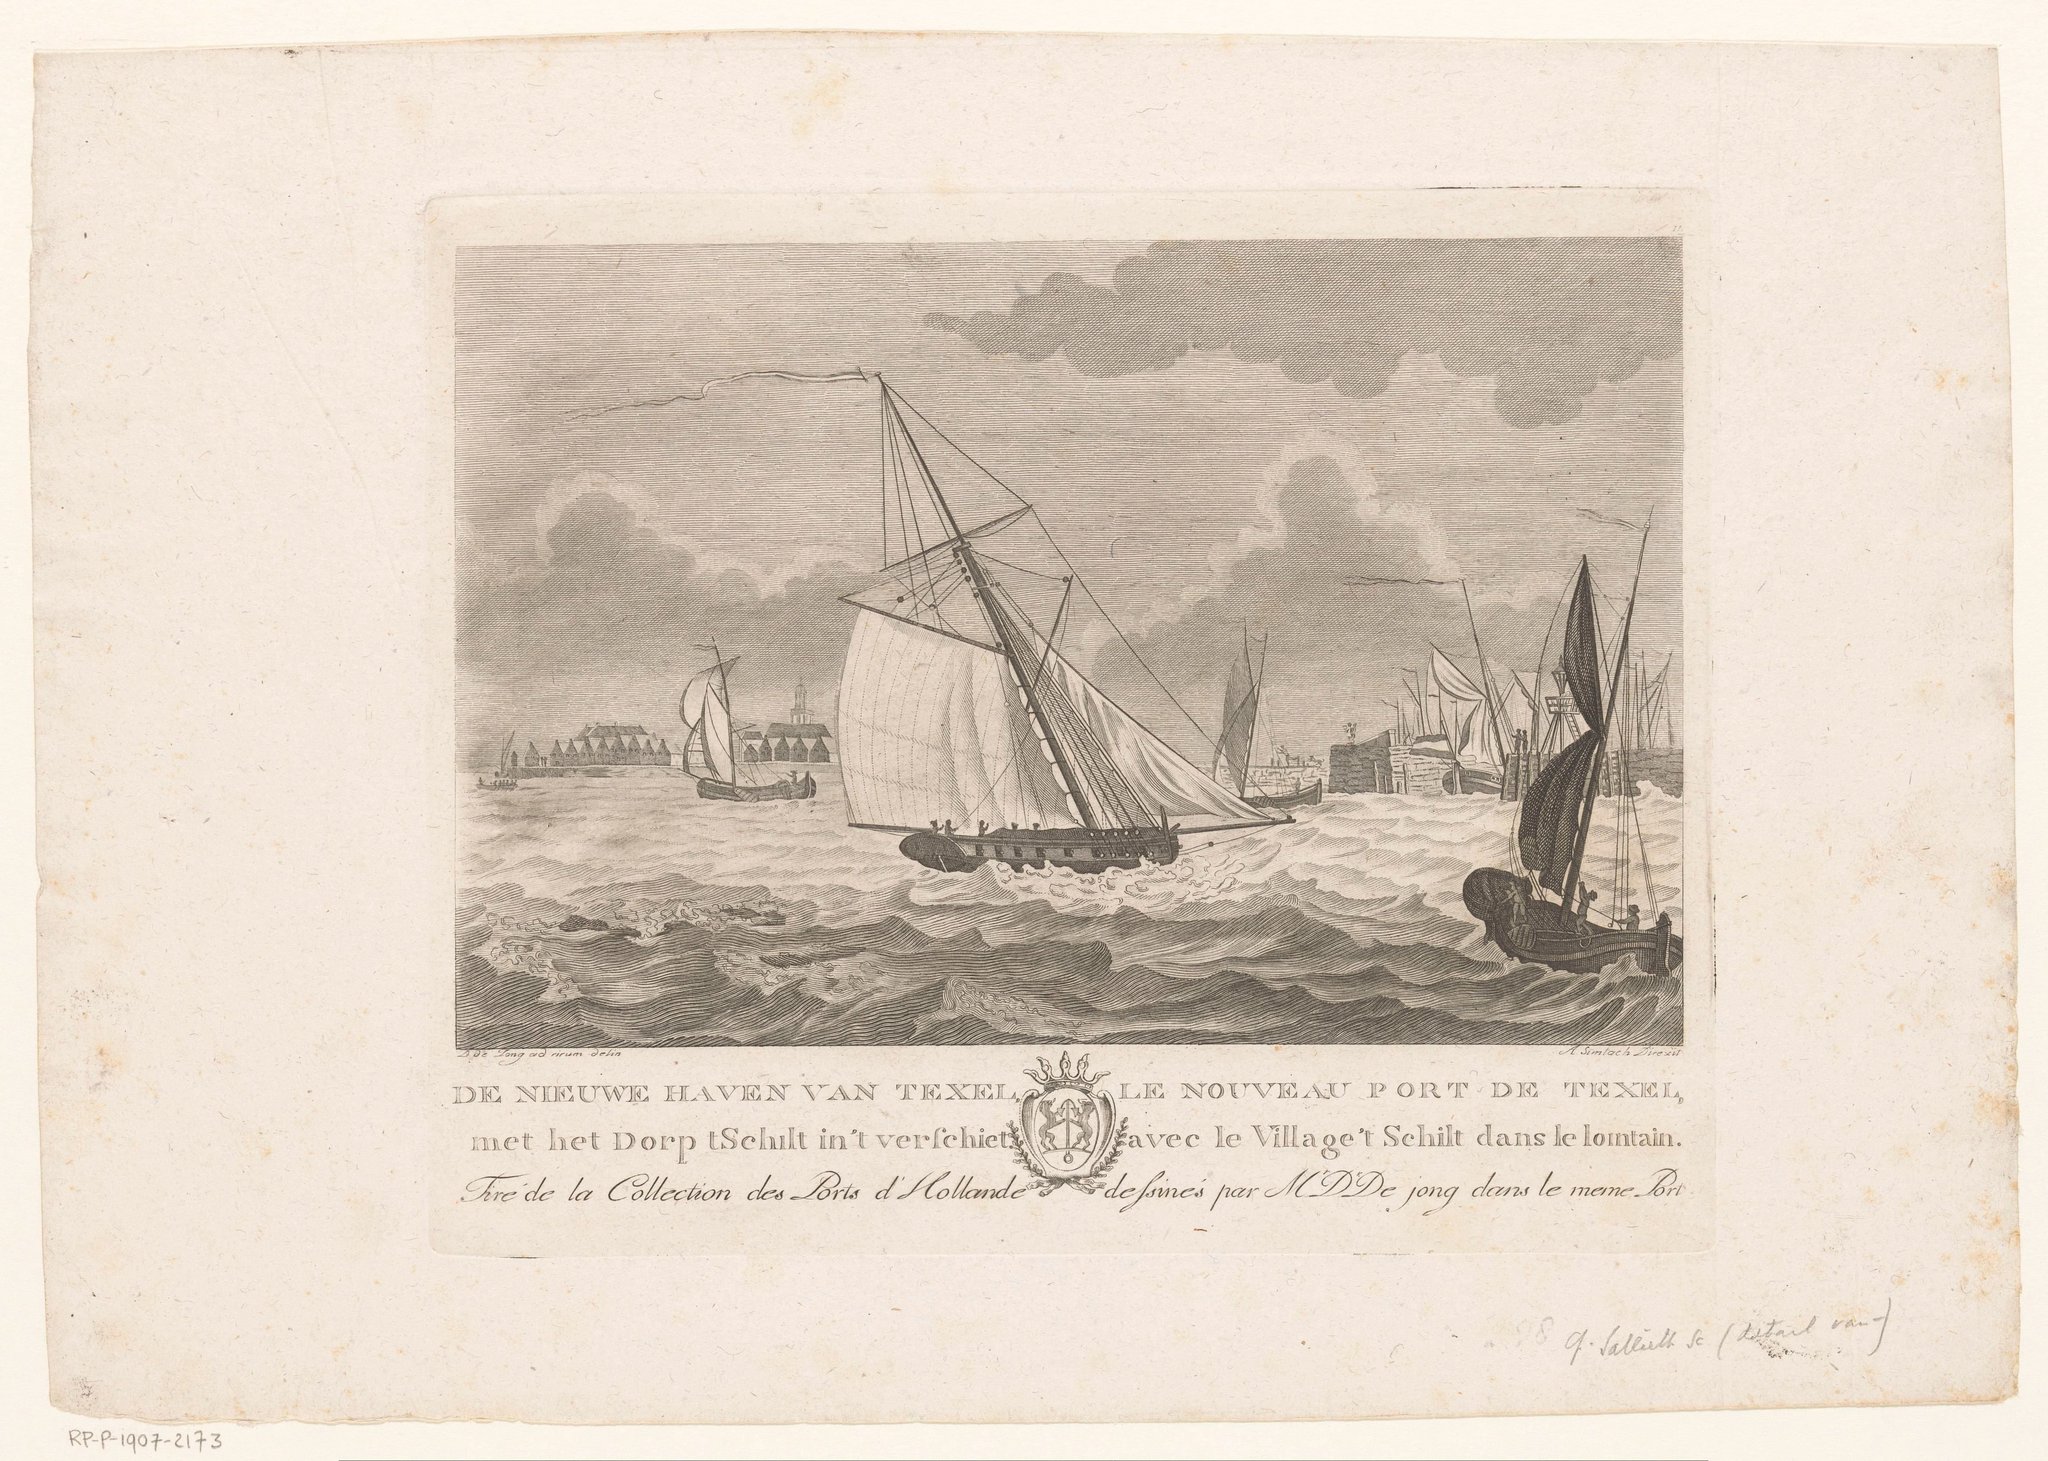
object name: print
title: De nieuwe haven van Texel / Le nouveau port de Texel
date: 1754-1828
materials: paper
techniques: engraving, etching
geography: italy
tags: harbour, ships (in general)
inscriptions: collector's mark: Lugt 2228